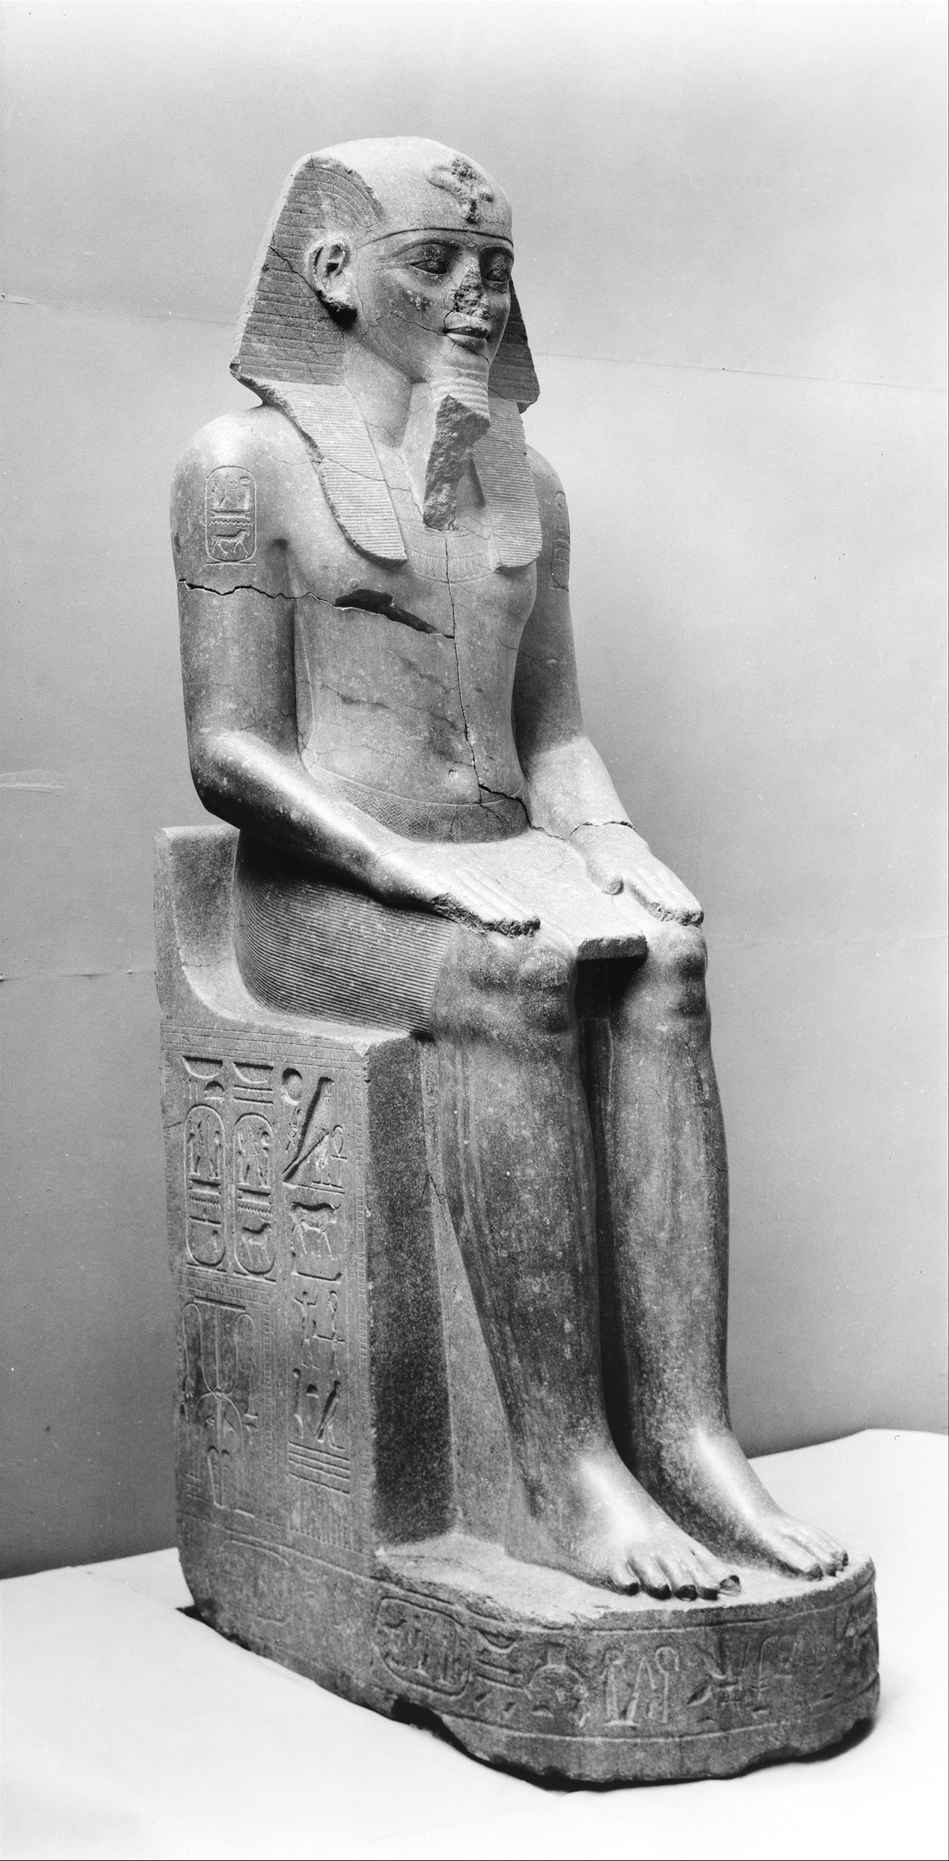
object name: statue, seated king, amenhotep iii, merneptah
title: Colossal Statue of Amenhotep III, reworked, reinscribed by Merneptah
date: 1390-1352 BCE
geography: egypt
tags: kings,hieroglyphs